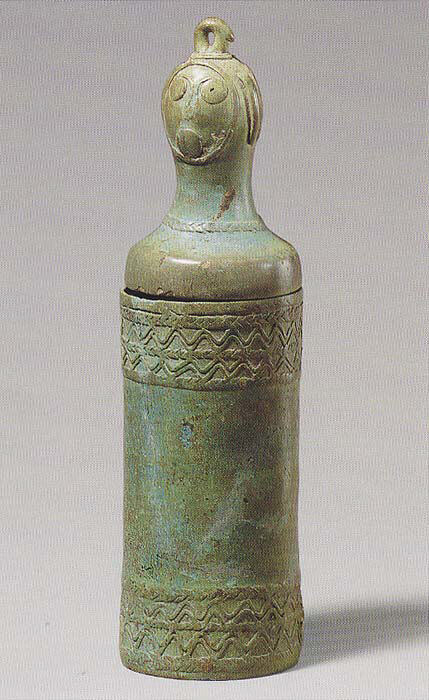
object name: lime container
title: Anthropomorphic Lime Container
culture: indonesian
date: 500 BCE-300 CE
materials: bronze